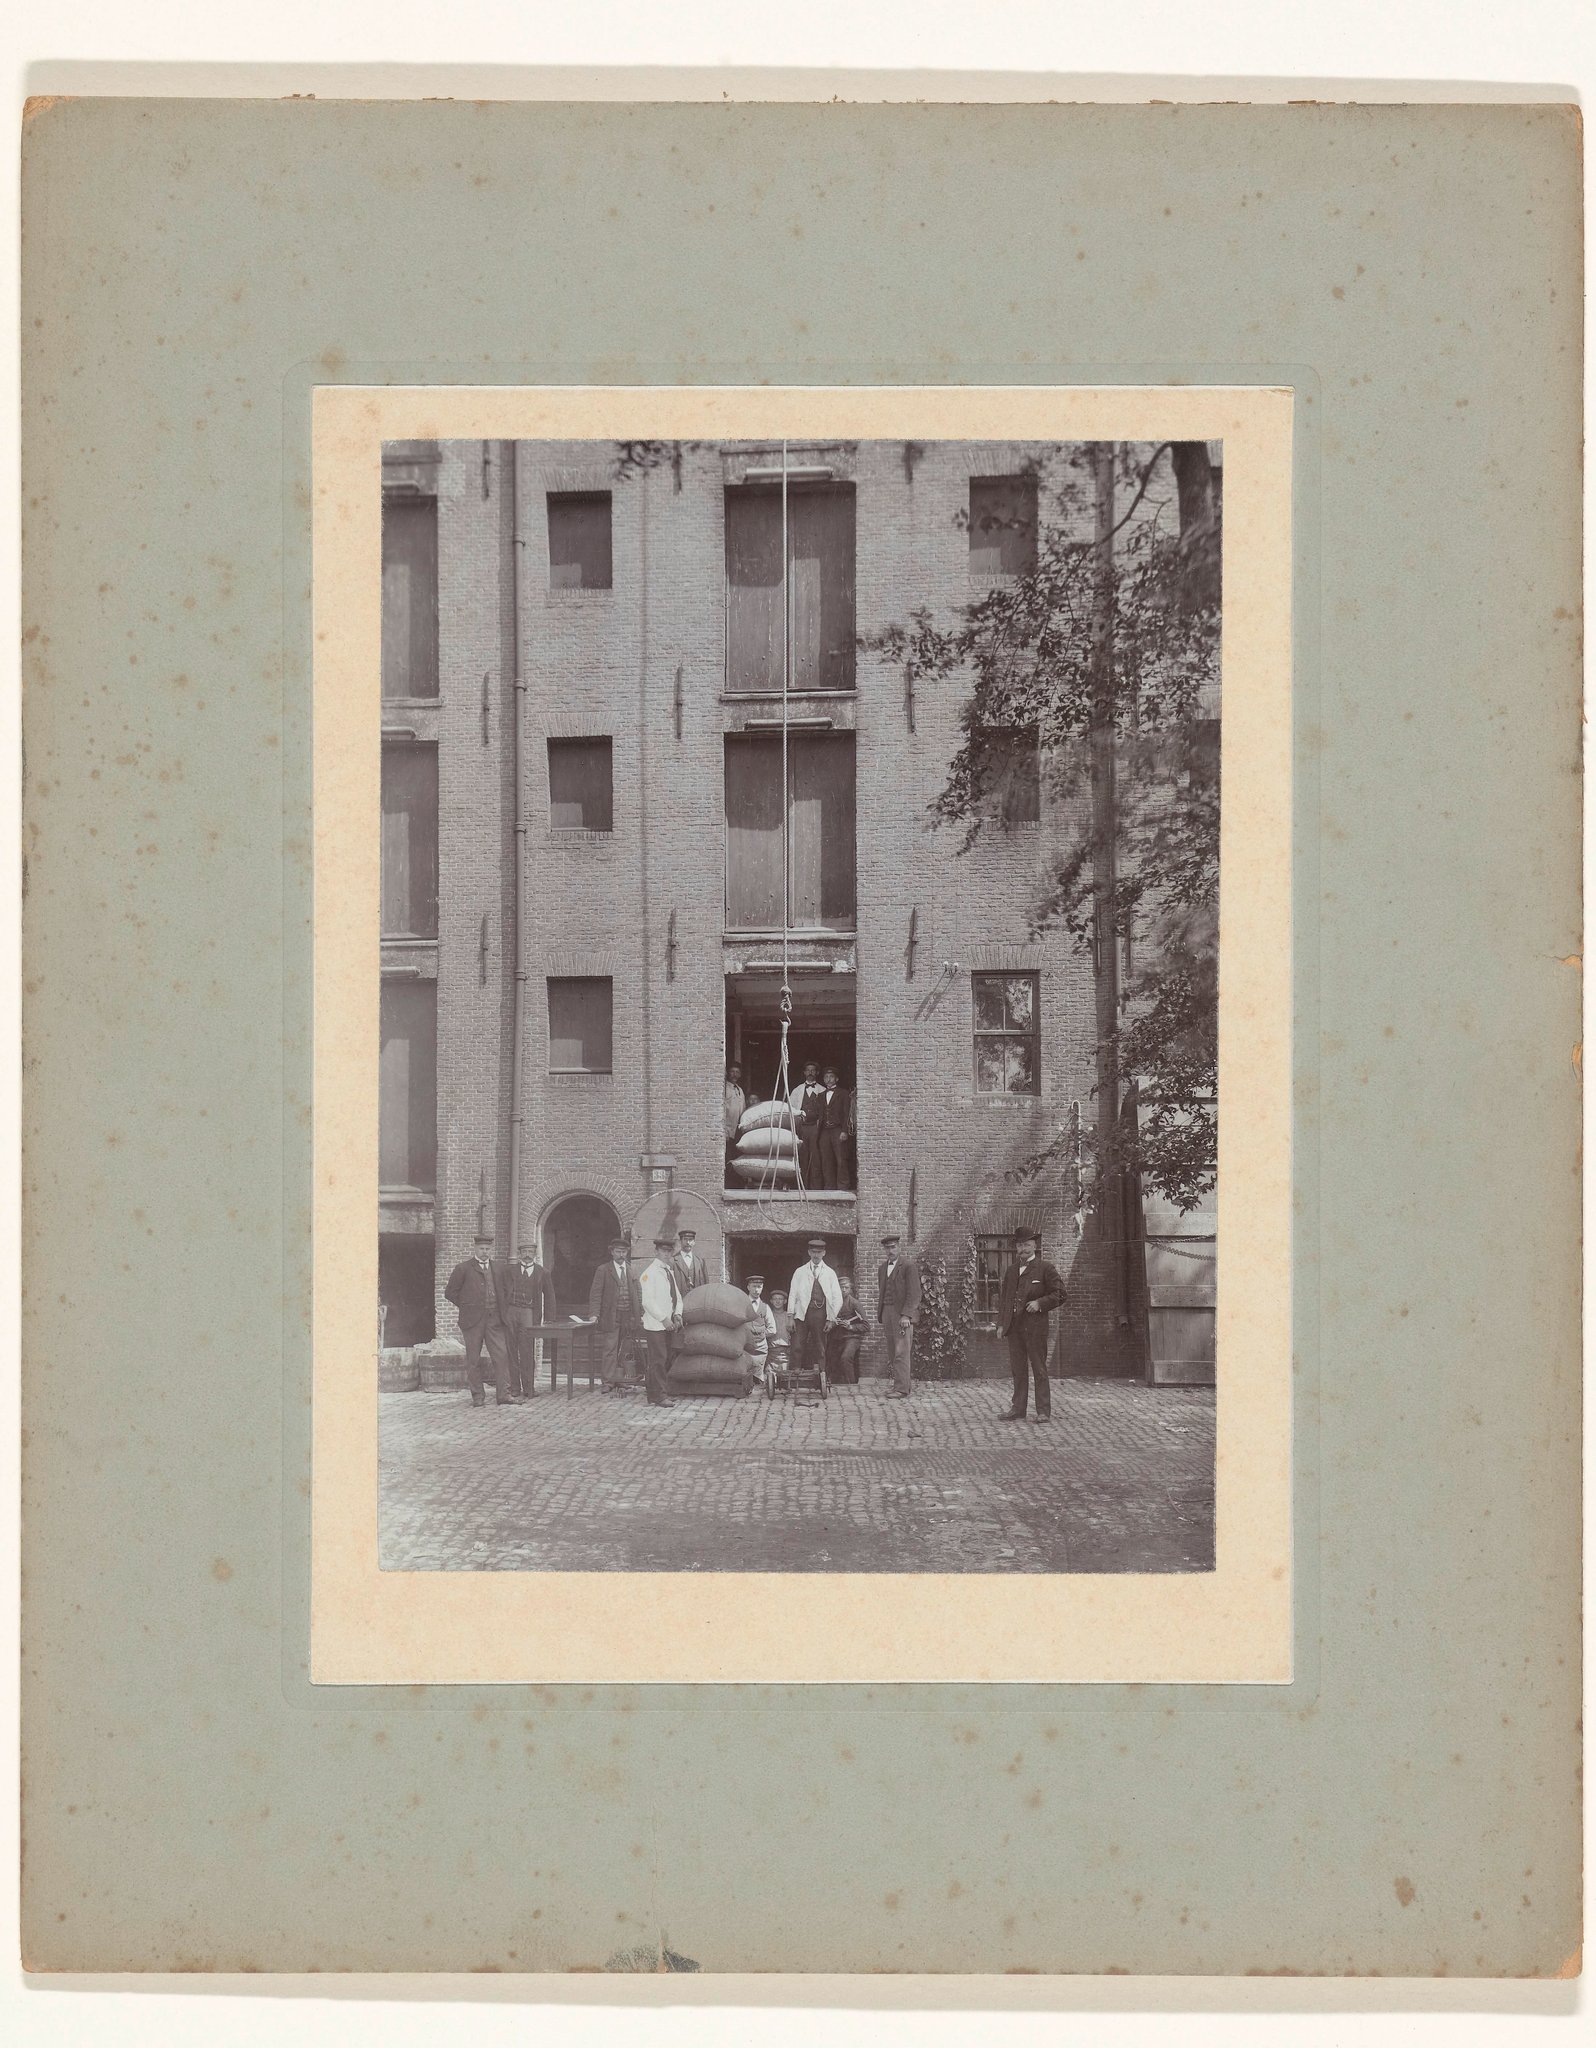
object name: photograph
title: Pakhuis met arbeiders, Amsterdam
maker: nicolaas schuitvlot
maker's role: fotograaf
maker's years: 1859-1947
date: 1900-1920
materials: paper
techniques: collodion silver print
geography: amsterdam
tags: warehouse (~ harbour), amsterdam